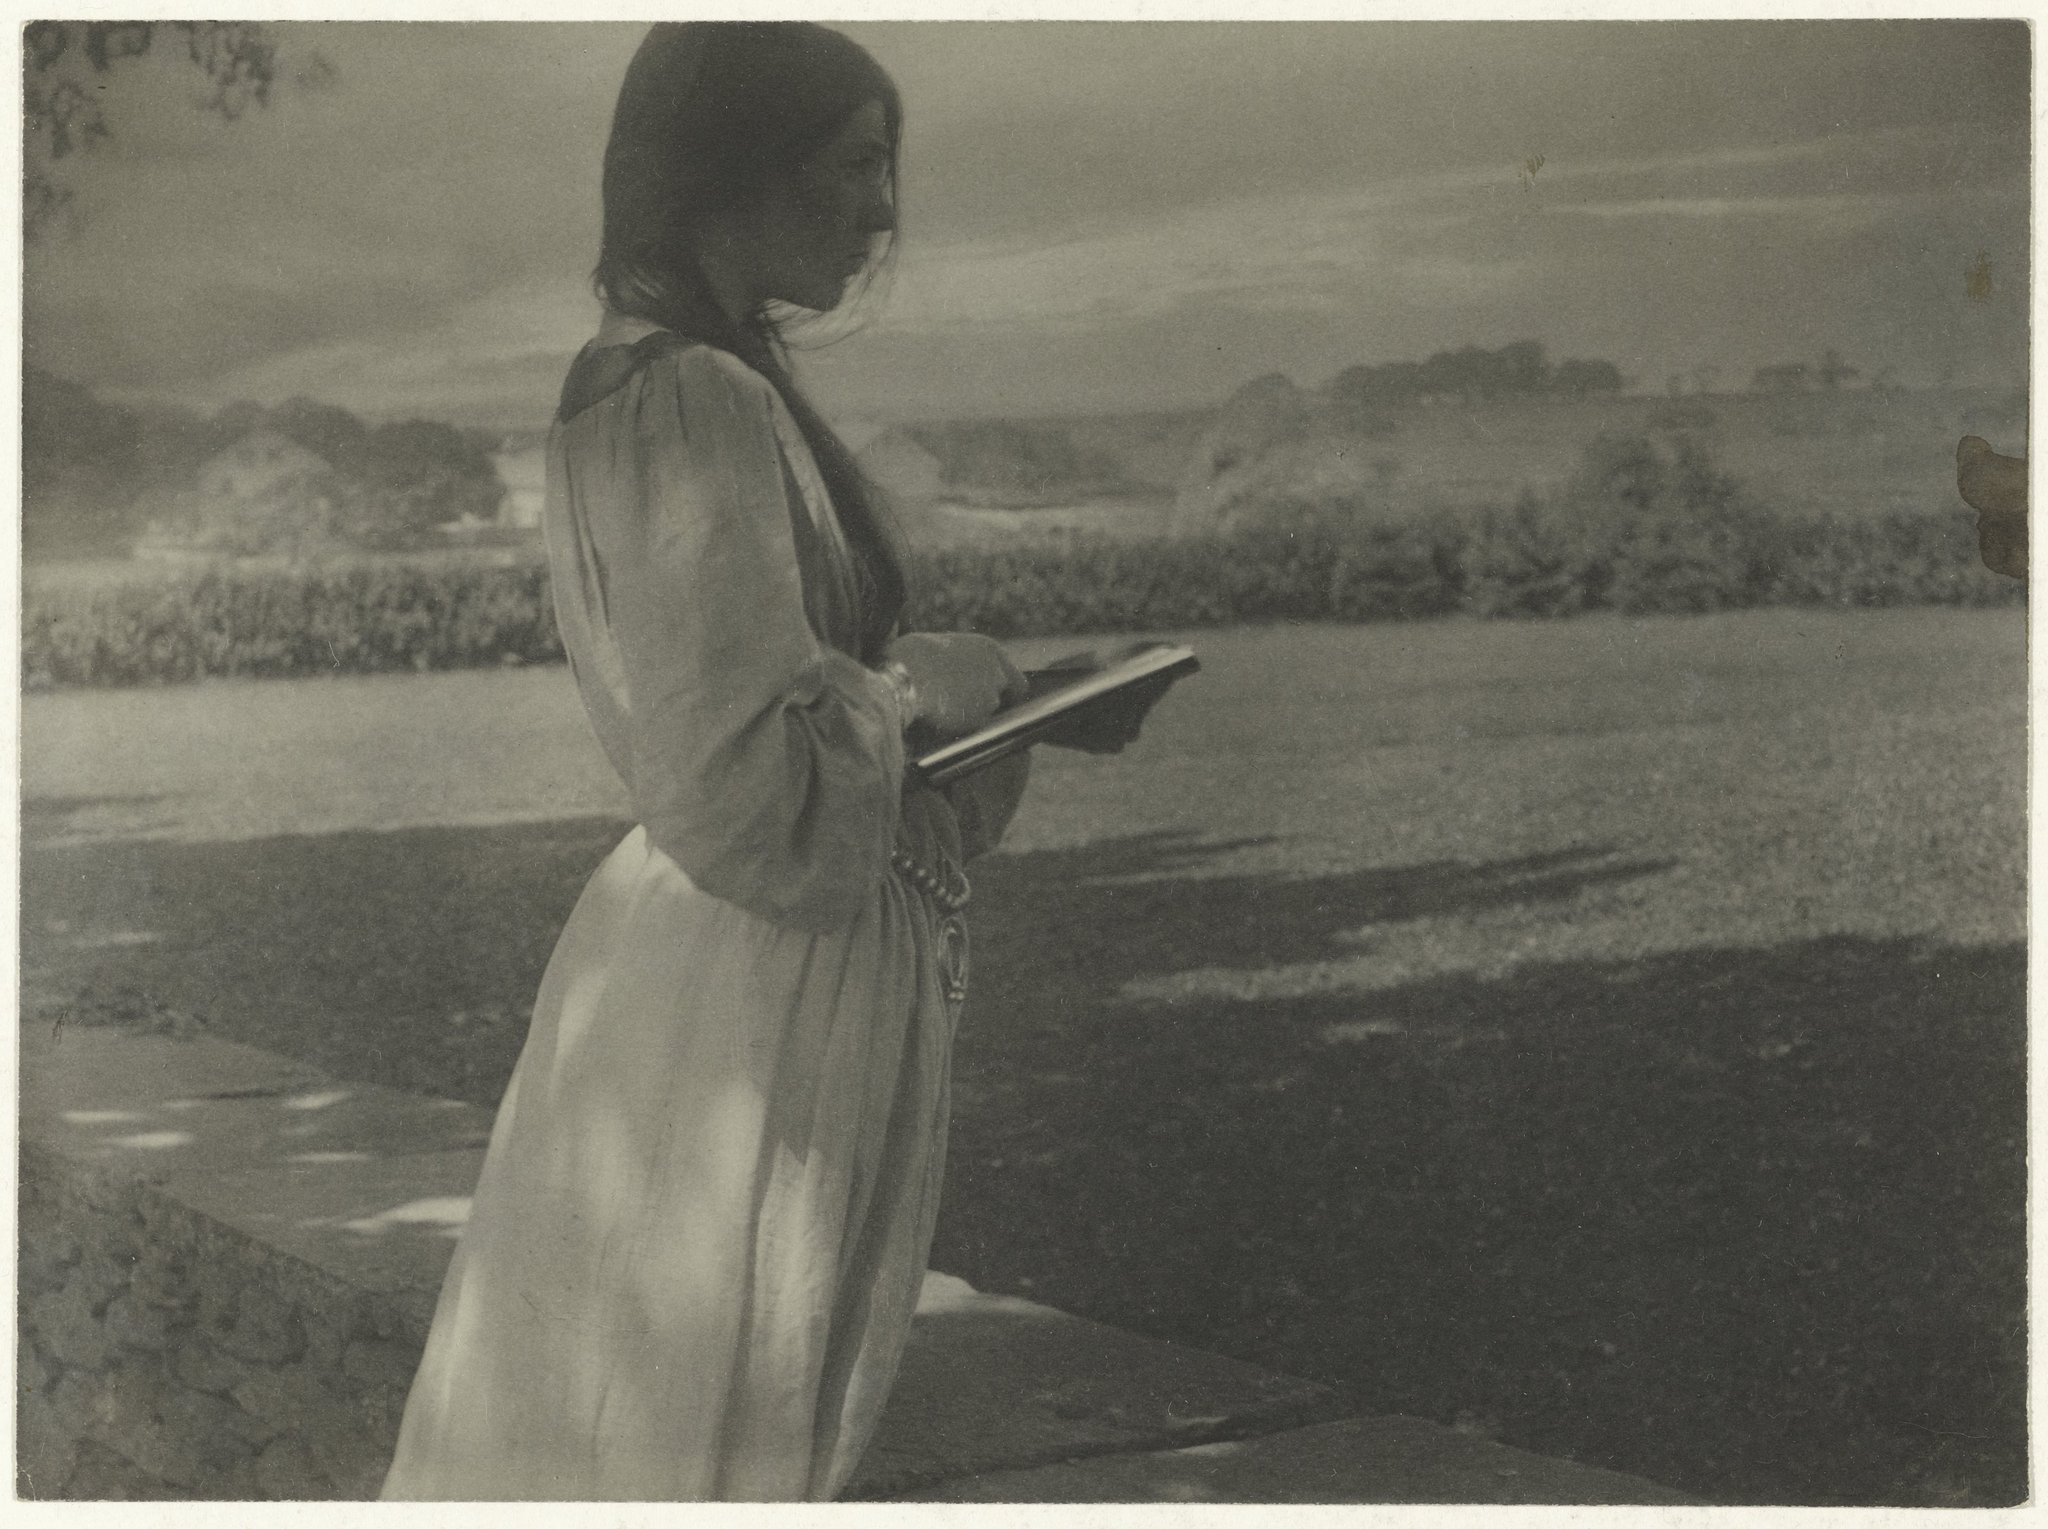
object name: photograph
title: The sketch (Beatrice Baxter Ruyl)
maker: gertrude käsebier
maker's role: fotograaf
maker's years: 1852-1934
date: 1902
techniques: platinum process